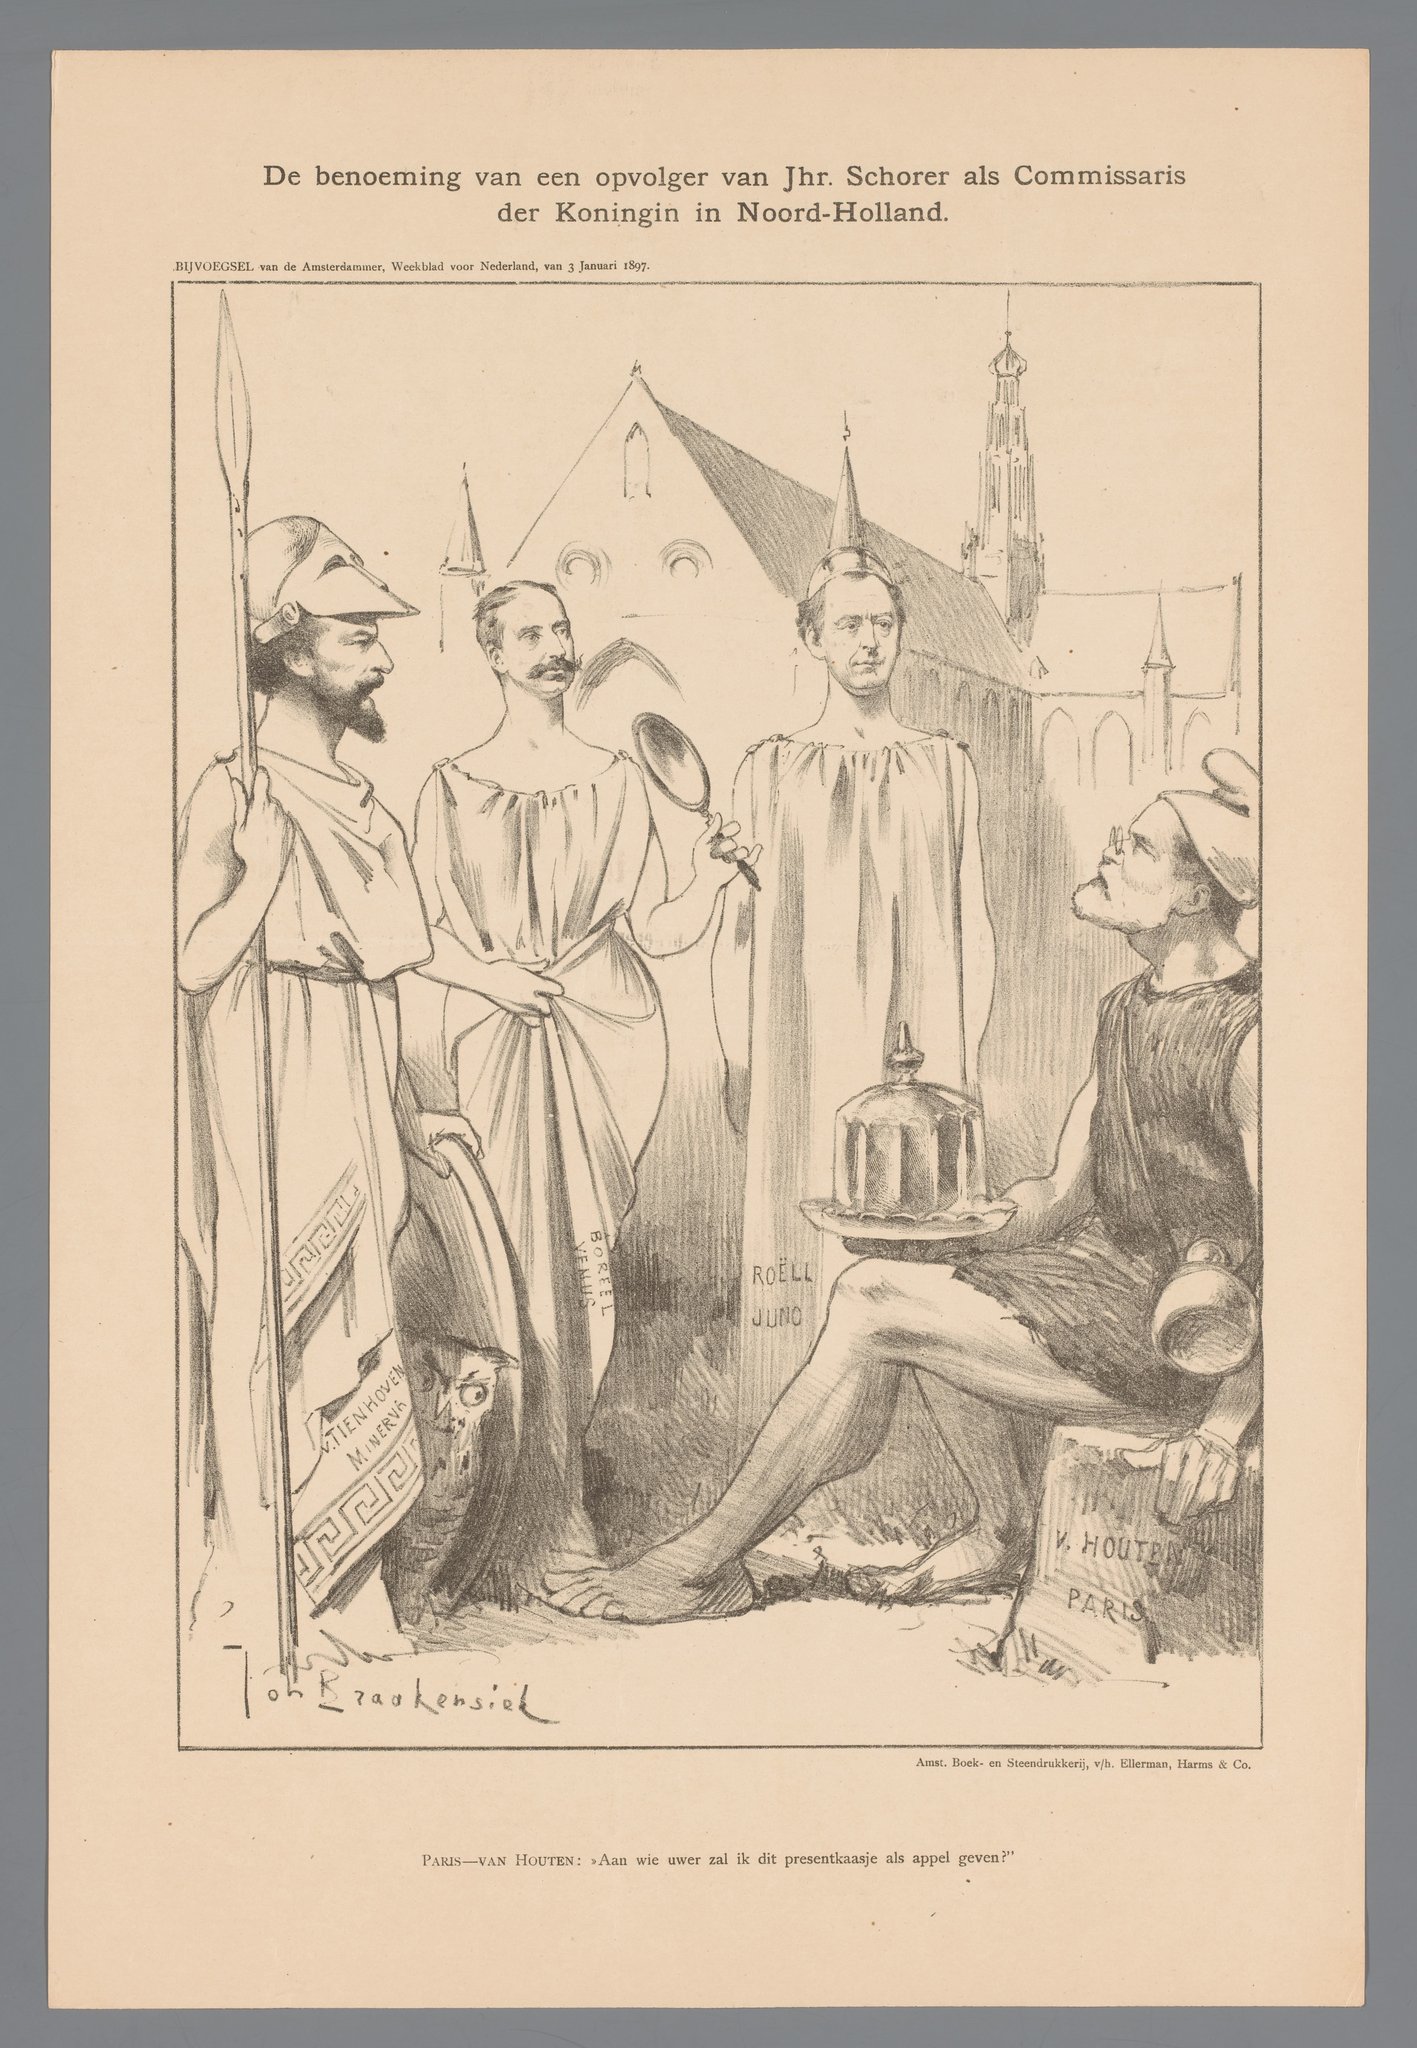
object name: cartoon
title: De benoeming van een opvolger van Jhr. Schorer als Commissaris der Koningin in Noord-Holland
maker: johan braakensiek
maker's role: draughtsman, print maker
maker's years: 1858-1940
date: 1897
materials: paper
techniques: lithograph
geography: amsterdam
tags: haarlem, the hague, politician, mayor, gijsbert van tienhoven, samuel van houten, the judgement of paris (without mercury), political caricatures and satires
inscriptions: date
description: Prent uit het bijvoegsel van: De Amsterdammer. Weekblad voor Nederland, 3 januari 1897.